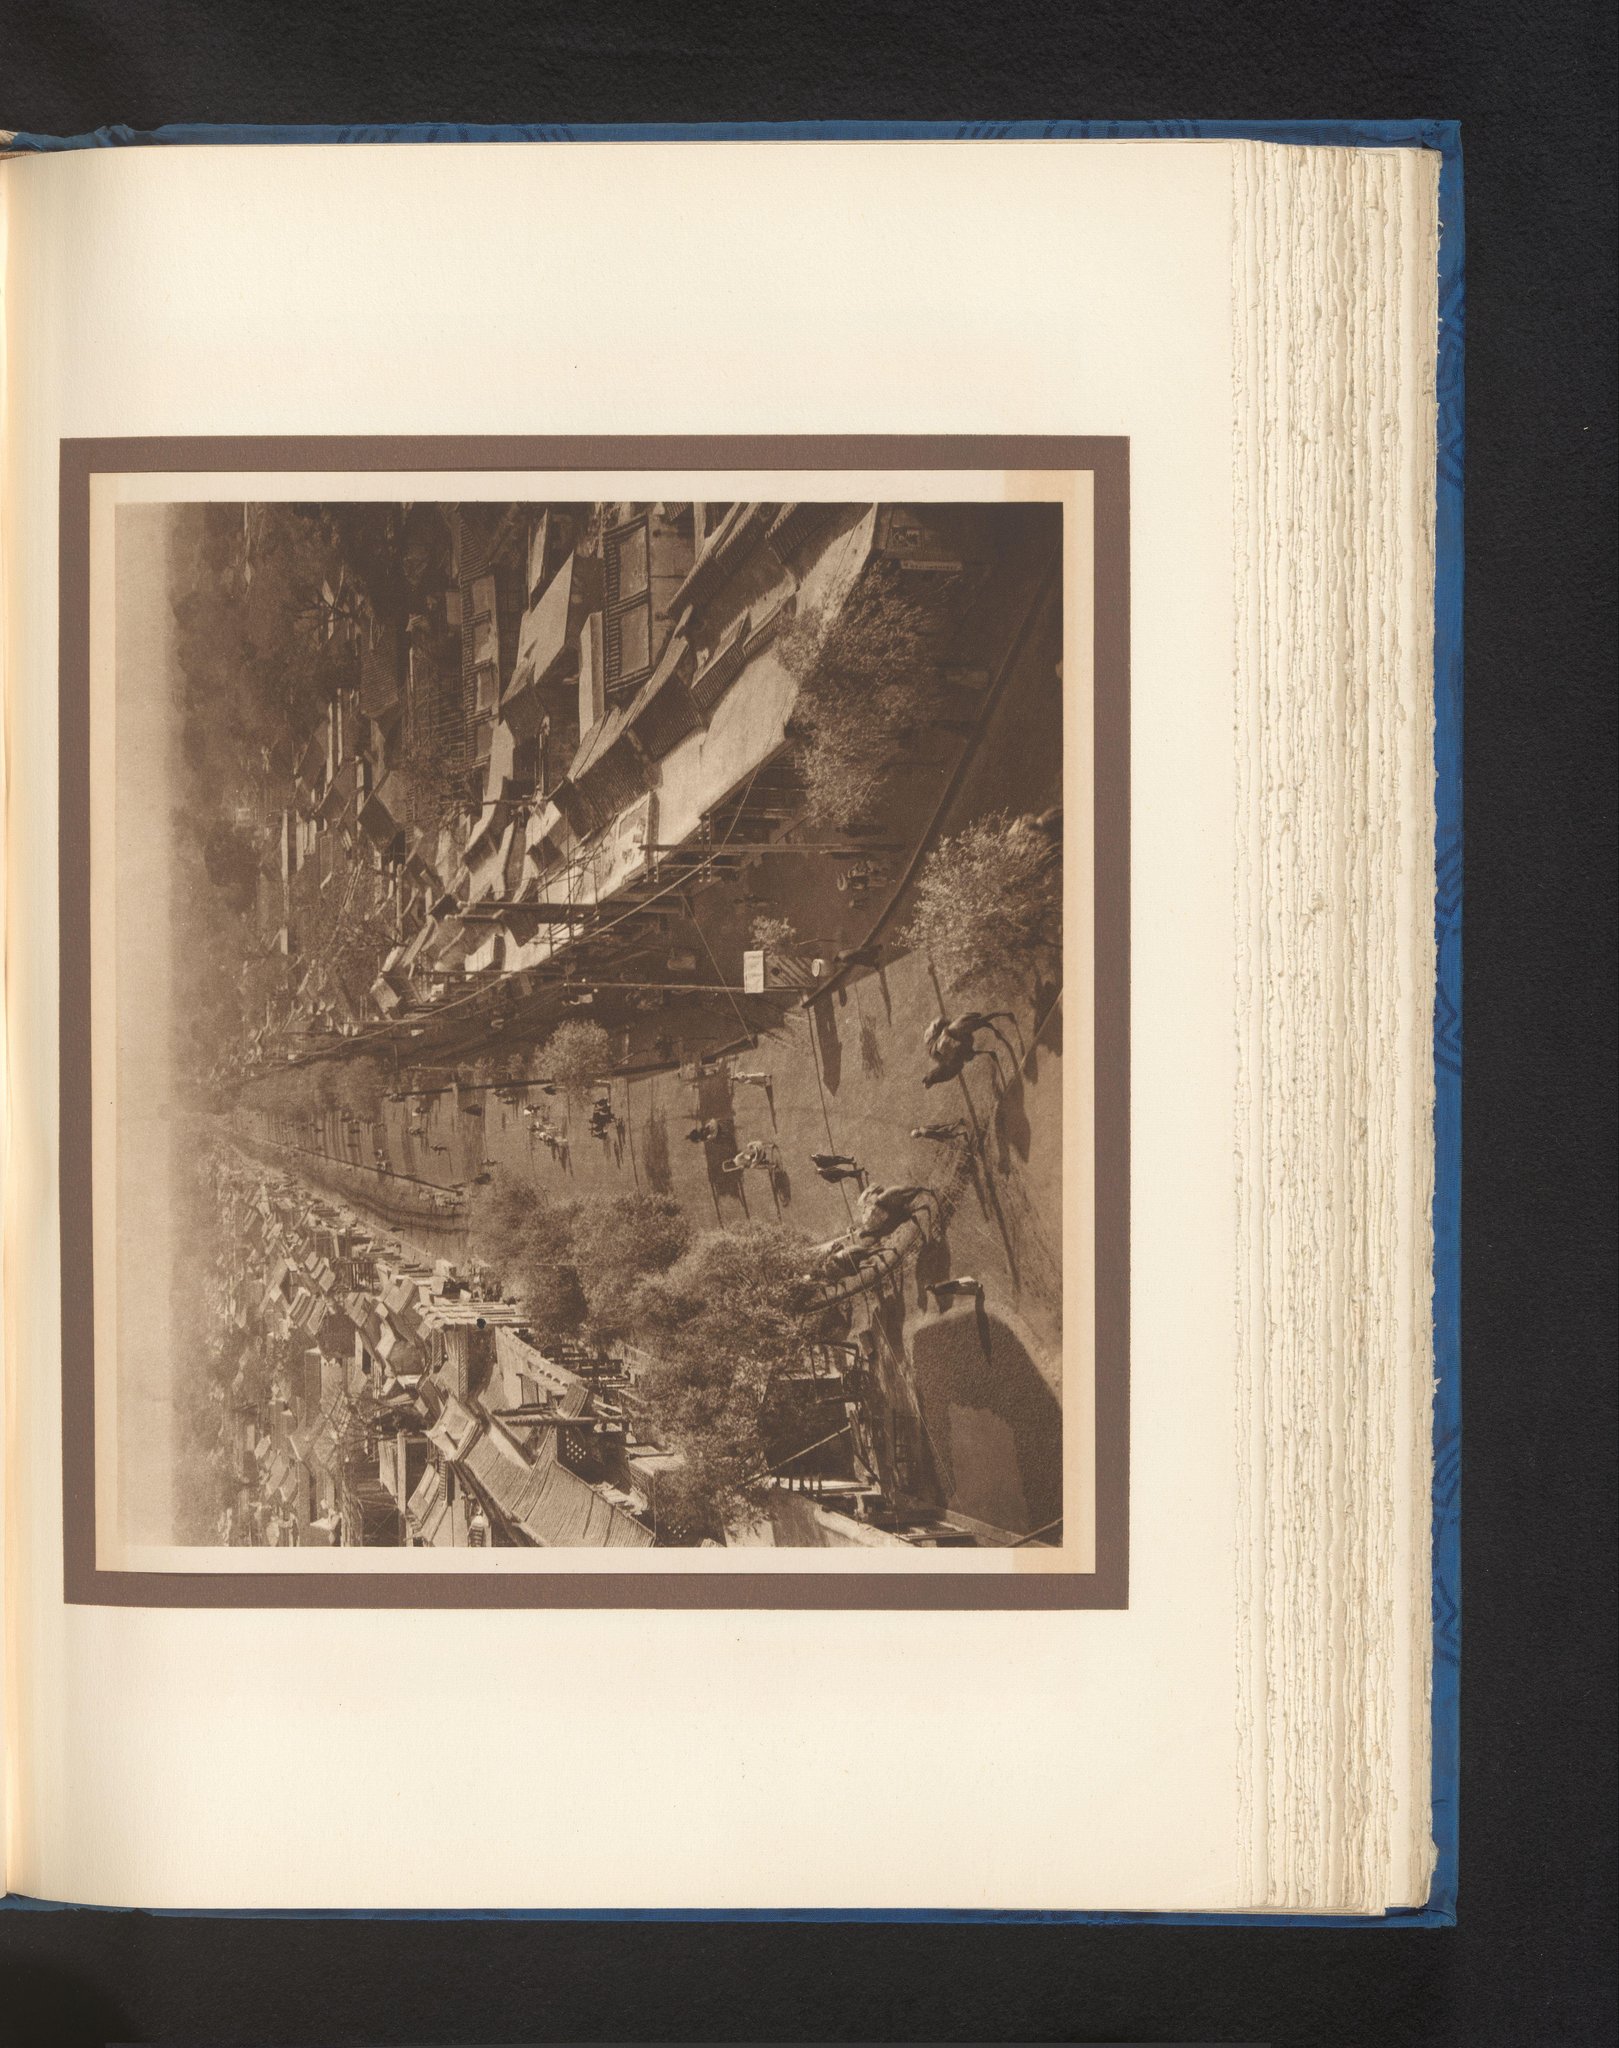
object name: page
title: Straatgezicht te Peking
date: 1915-1920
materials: paper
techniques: rotogravure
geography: beijing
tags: street